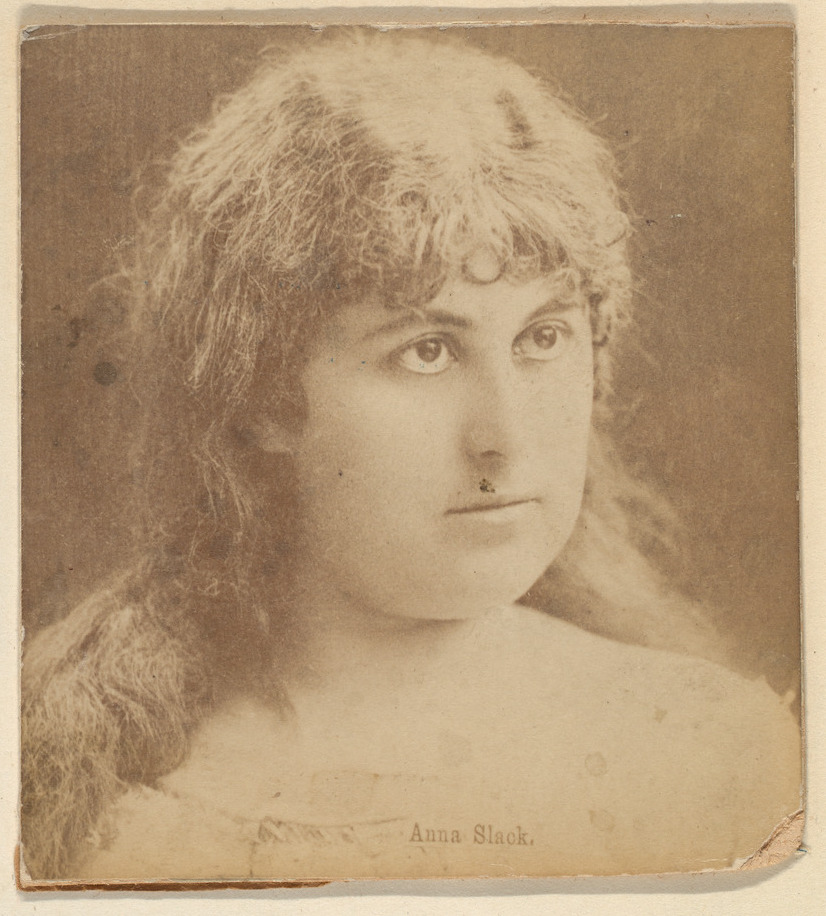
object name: photograph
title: Anna Slack, from the Actresses series (N246), Type 2, issued by Kinney Brothers to promote Sporting Extra Cigarettes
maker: kinney brothers tobacco company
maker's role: publisher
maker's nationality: american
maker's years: 1869-2011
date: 1890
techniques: albumen silver print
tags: portraits,women,actresses